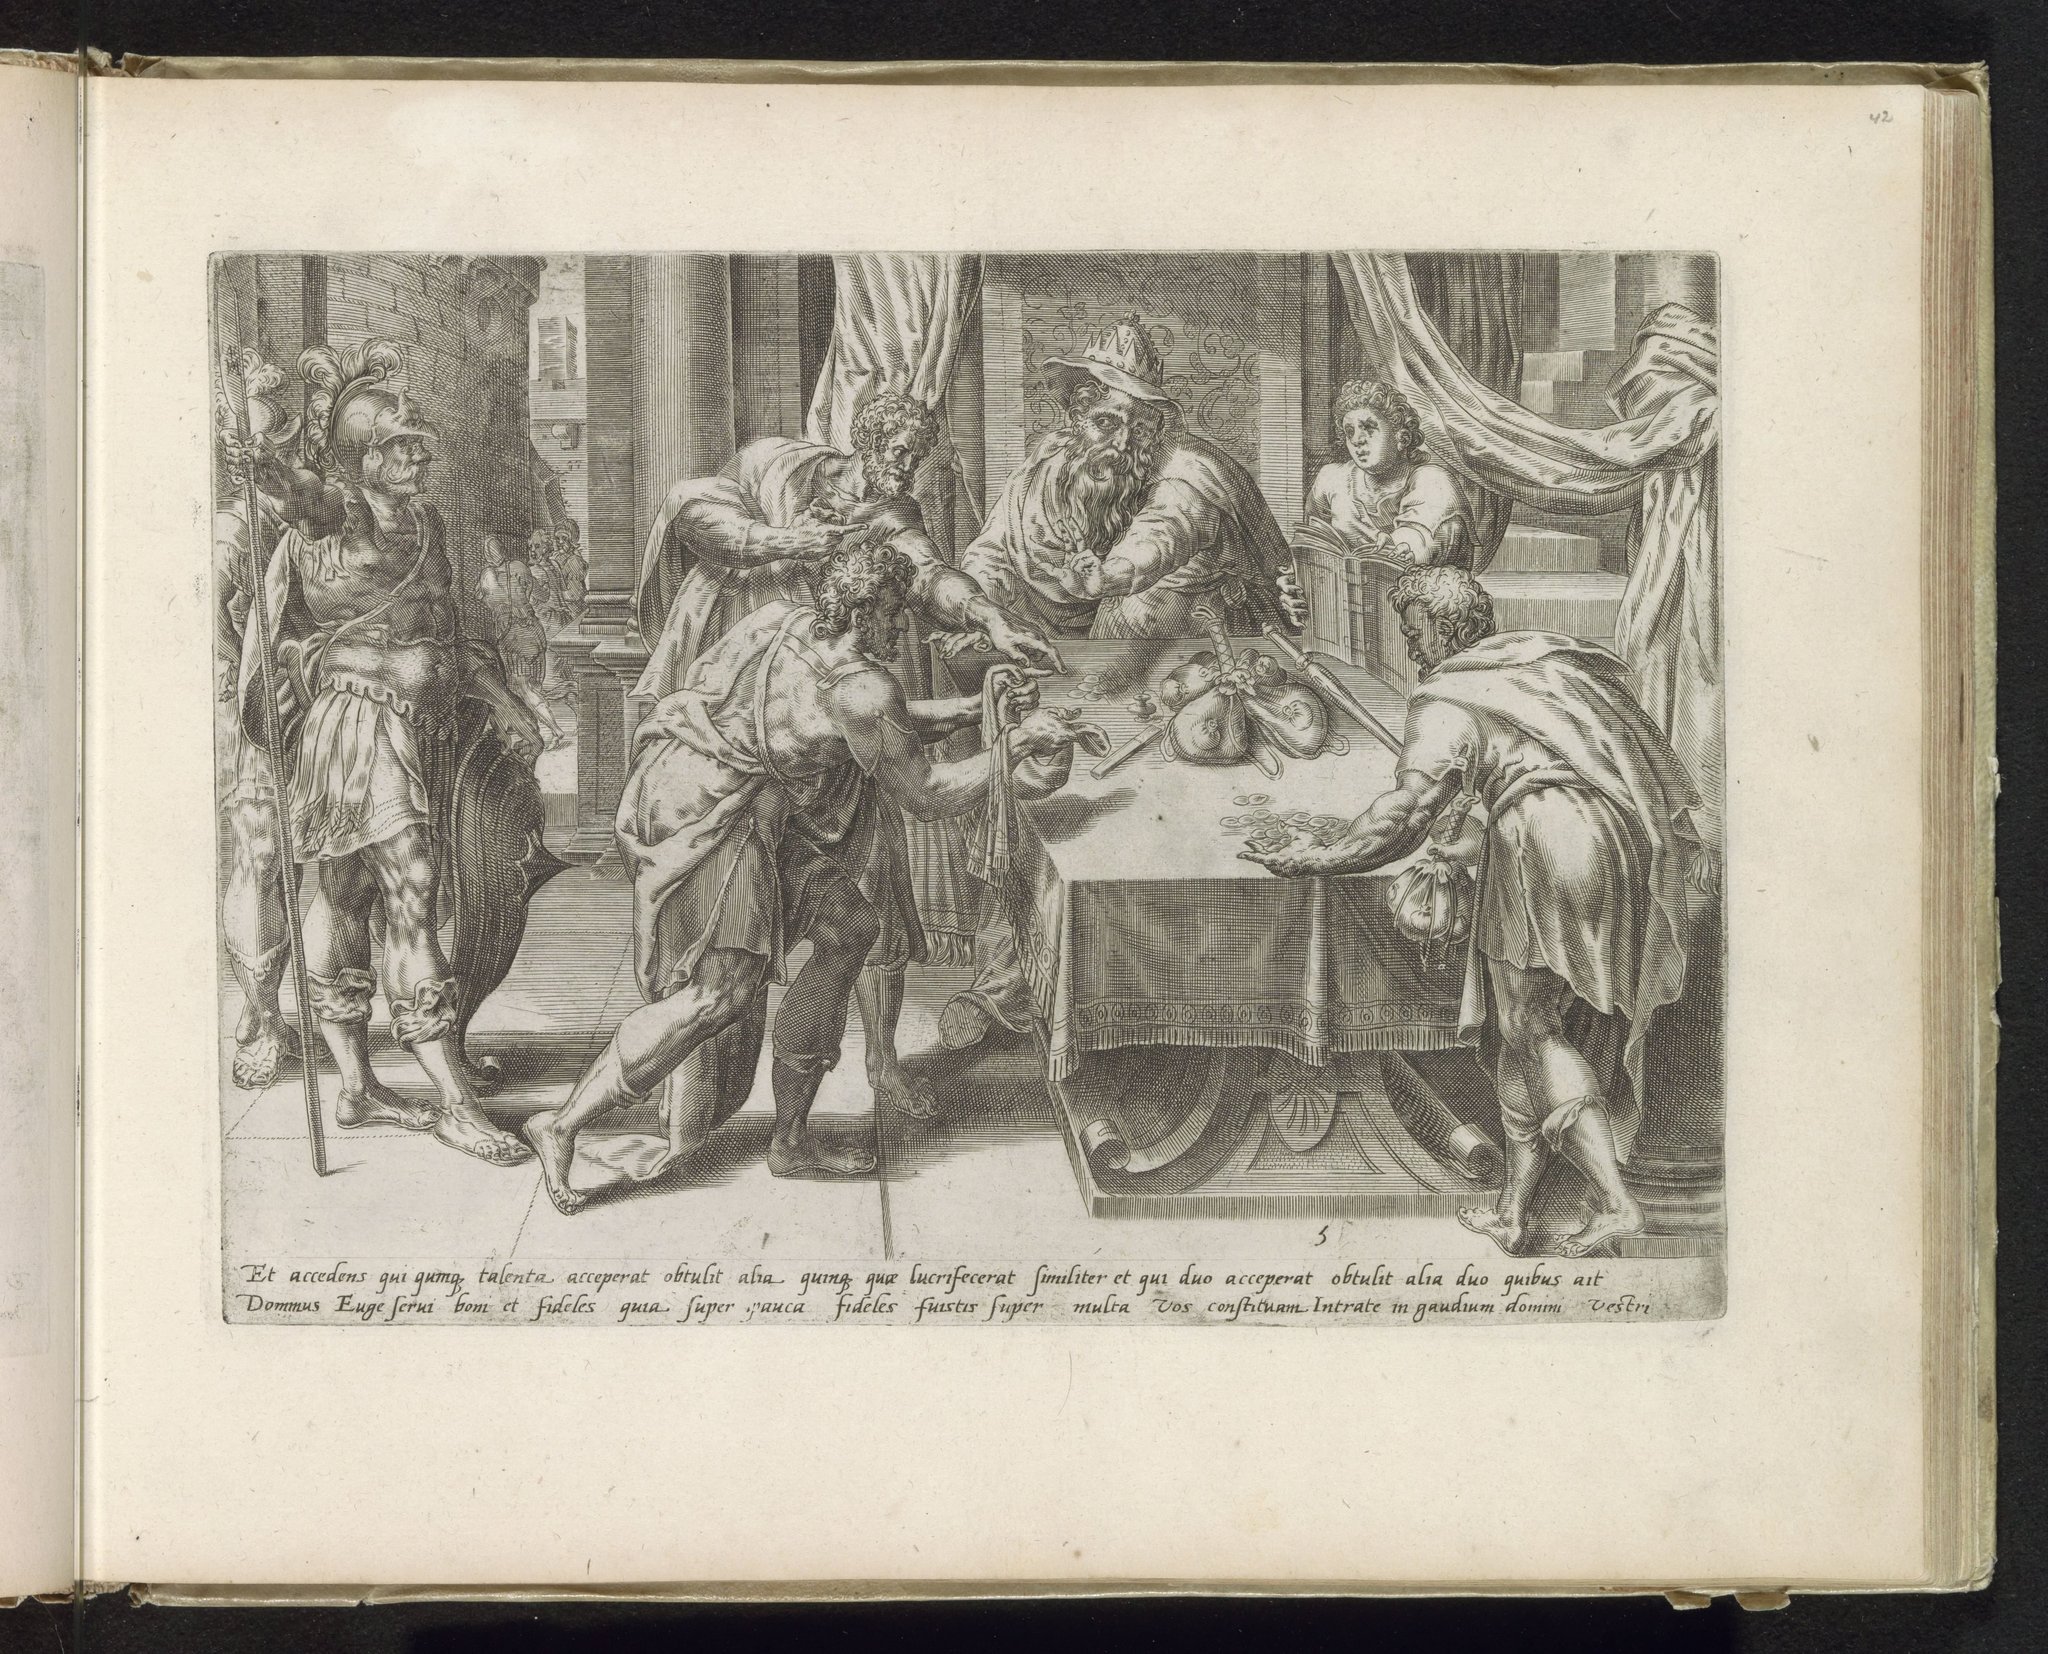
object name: album leaf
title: Thesaurus novi Testamenti elegantissimis iconibus expressus continens historias atque miracula doni nostri Iesu Christi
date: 1585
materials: paper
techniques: engraving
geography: antwerp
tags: after the return of the lord the servants account for their debts and are rewarded accordingly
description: De heer vraagt zijn drie dienaren om rekenschap. Degenen met vijf talenten en twee talenten hebben allebei hetzelfde bedrag erbij verdiend. De laatste dienaar legt zijn bundel met een talent op tafel en geeft de heer precies hetzelfde terug als wat hij gekregen had. Onder de voorstelling een verwijzing in het Latijn naar de Bijbeltekst in Mat. 25. Deze prent maakt deel uit van een album.